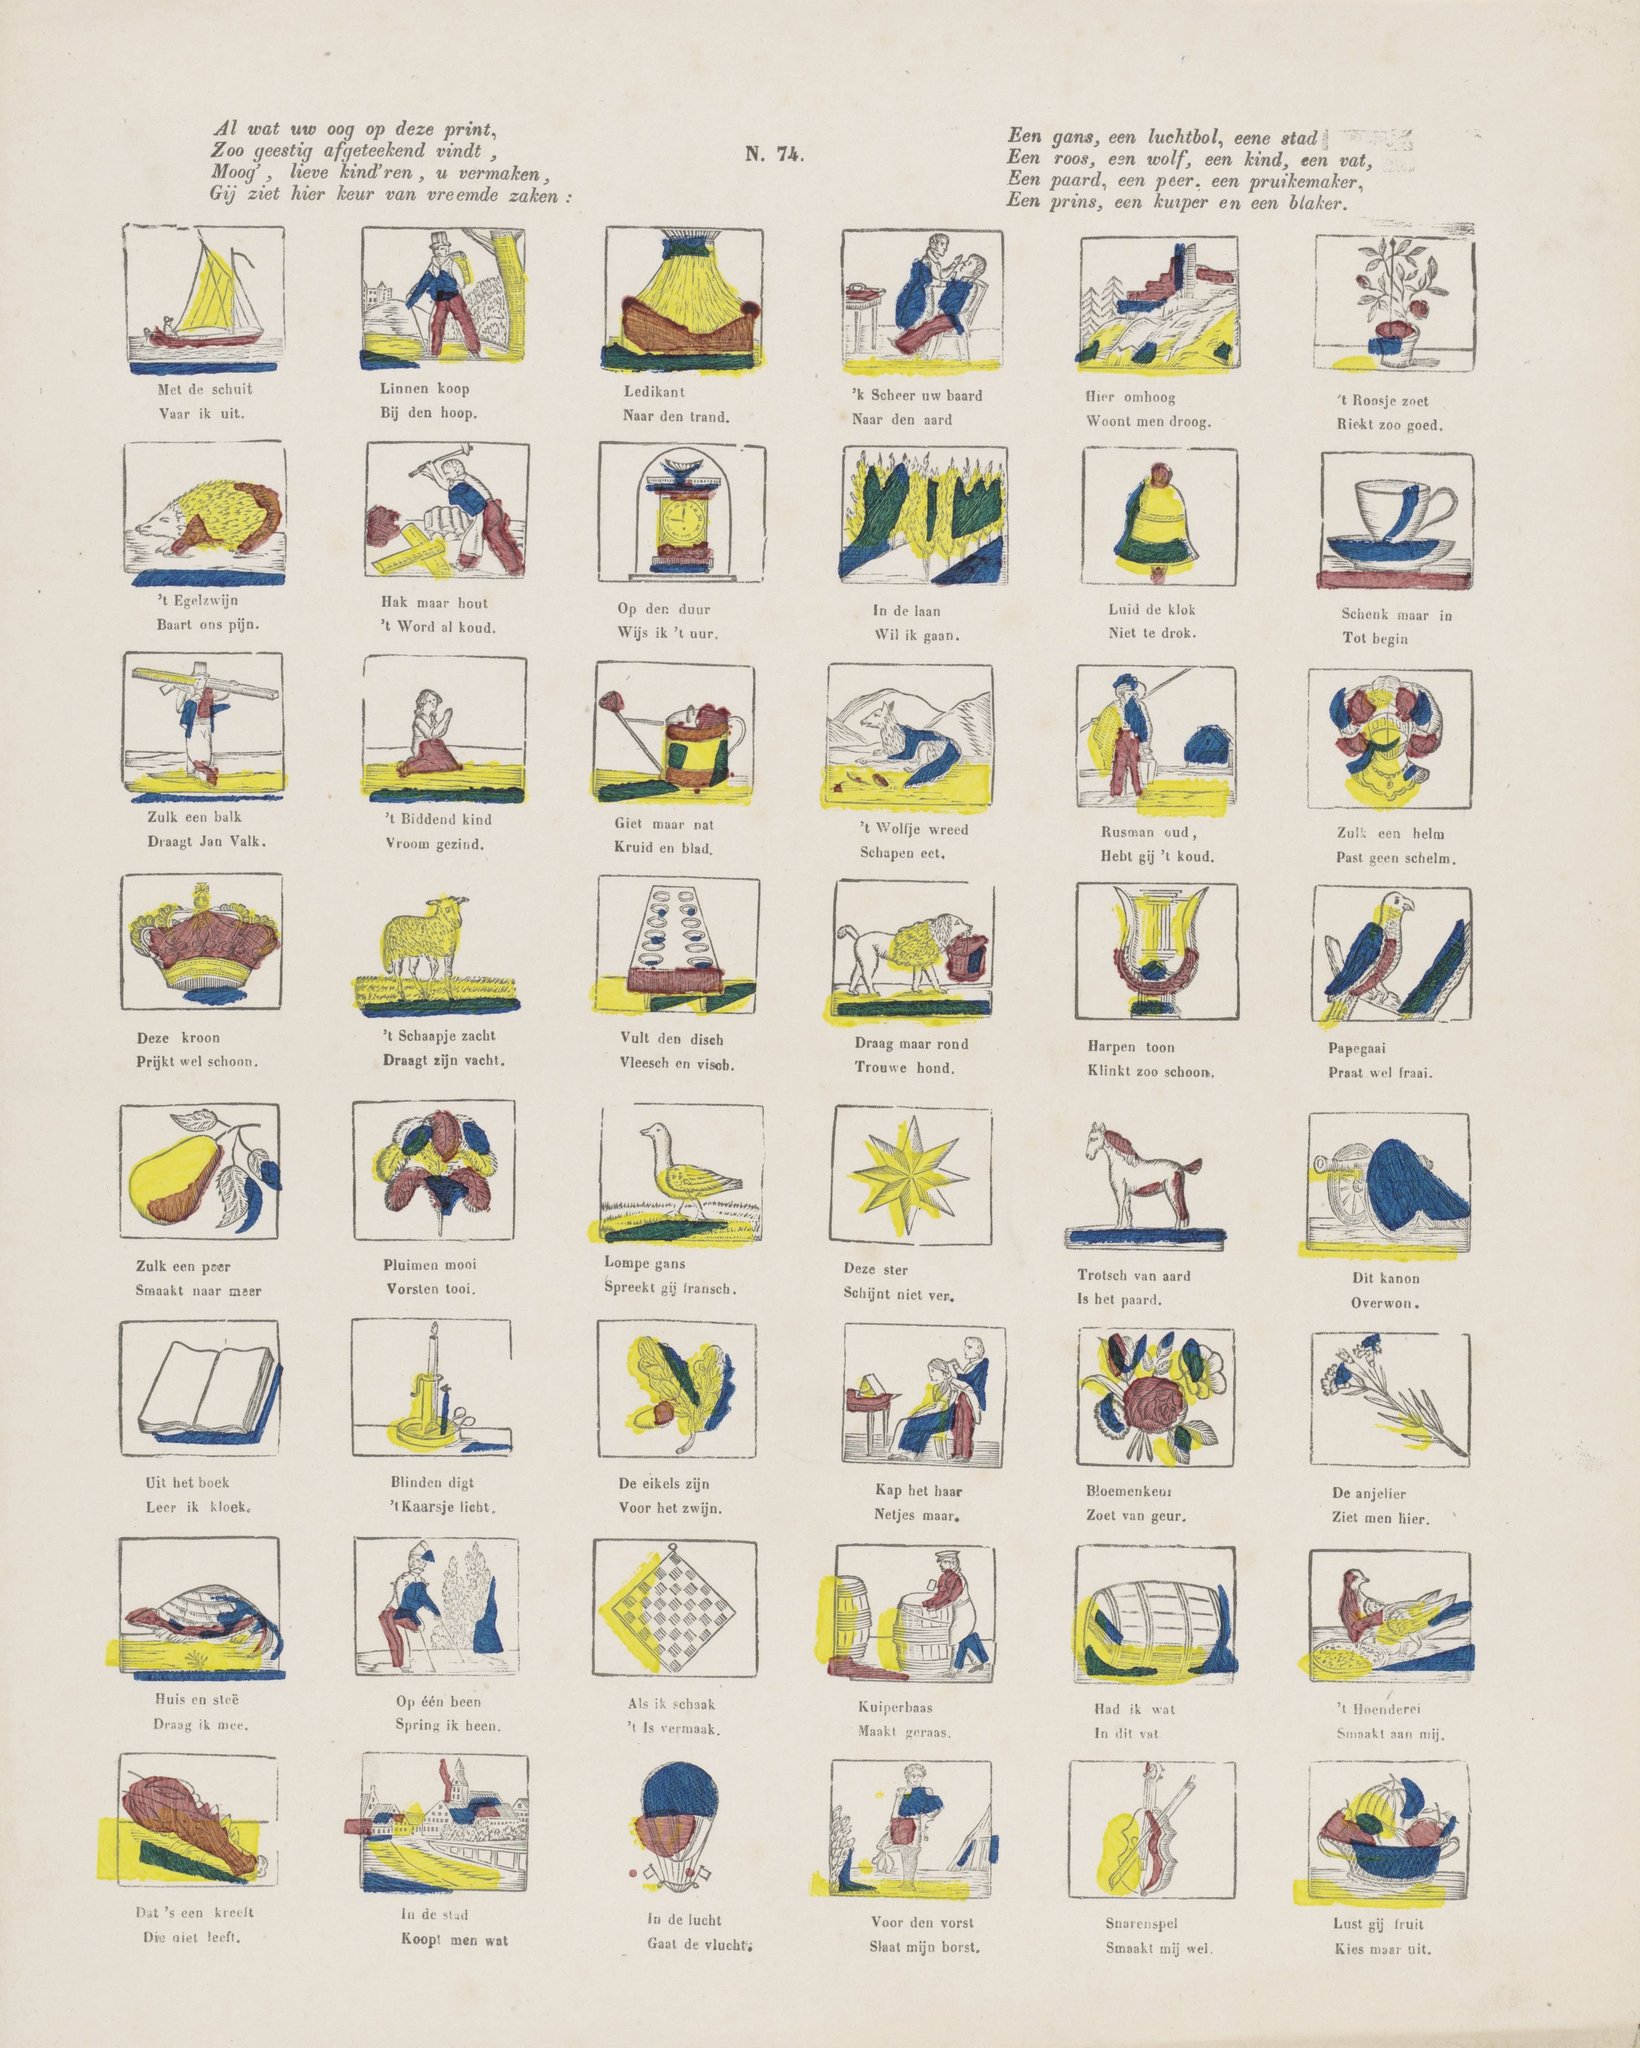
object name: print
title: Al wat ge uw oog op deze print, / Zoo geestig afgeteekend vindt [(...)]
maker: Anonymous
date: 1848-1881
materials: paper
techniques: colour, letterpress printing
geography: den bosch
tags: musical instruments; group of musical instruments, animals, human types, characters (human types), (household) utensils and implements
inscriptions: collector's mark: Lugt 2760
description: Blad met 48 voorstellingen van voorwerpen, figuren en dieren. Onder elke voorstelling een tweeregelig vers. Genummerd midden boven: N. 74.